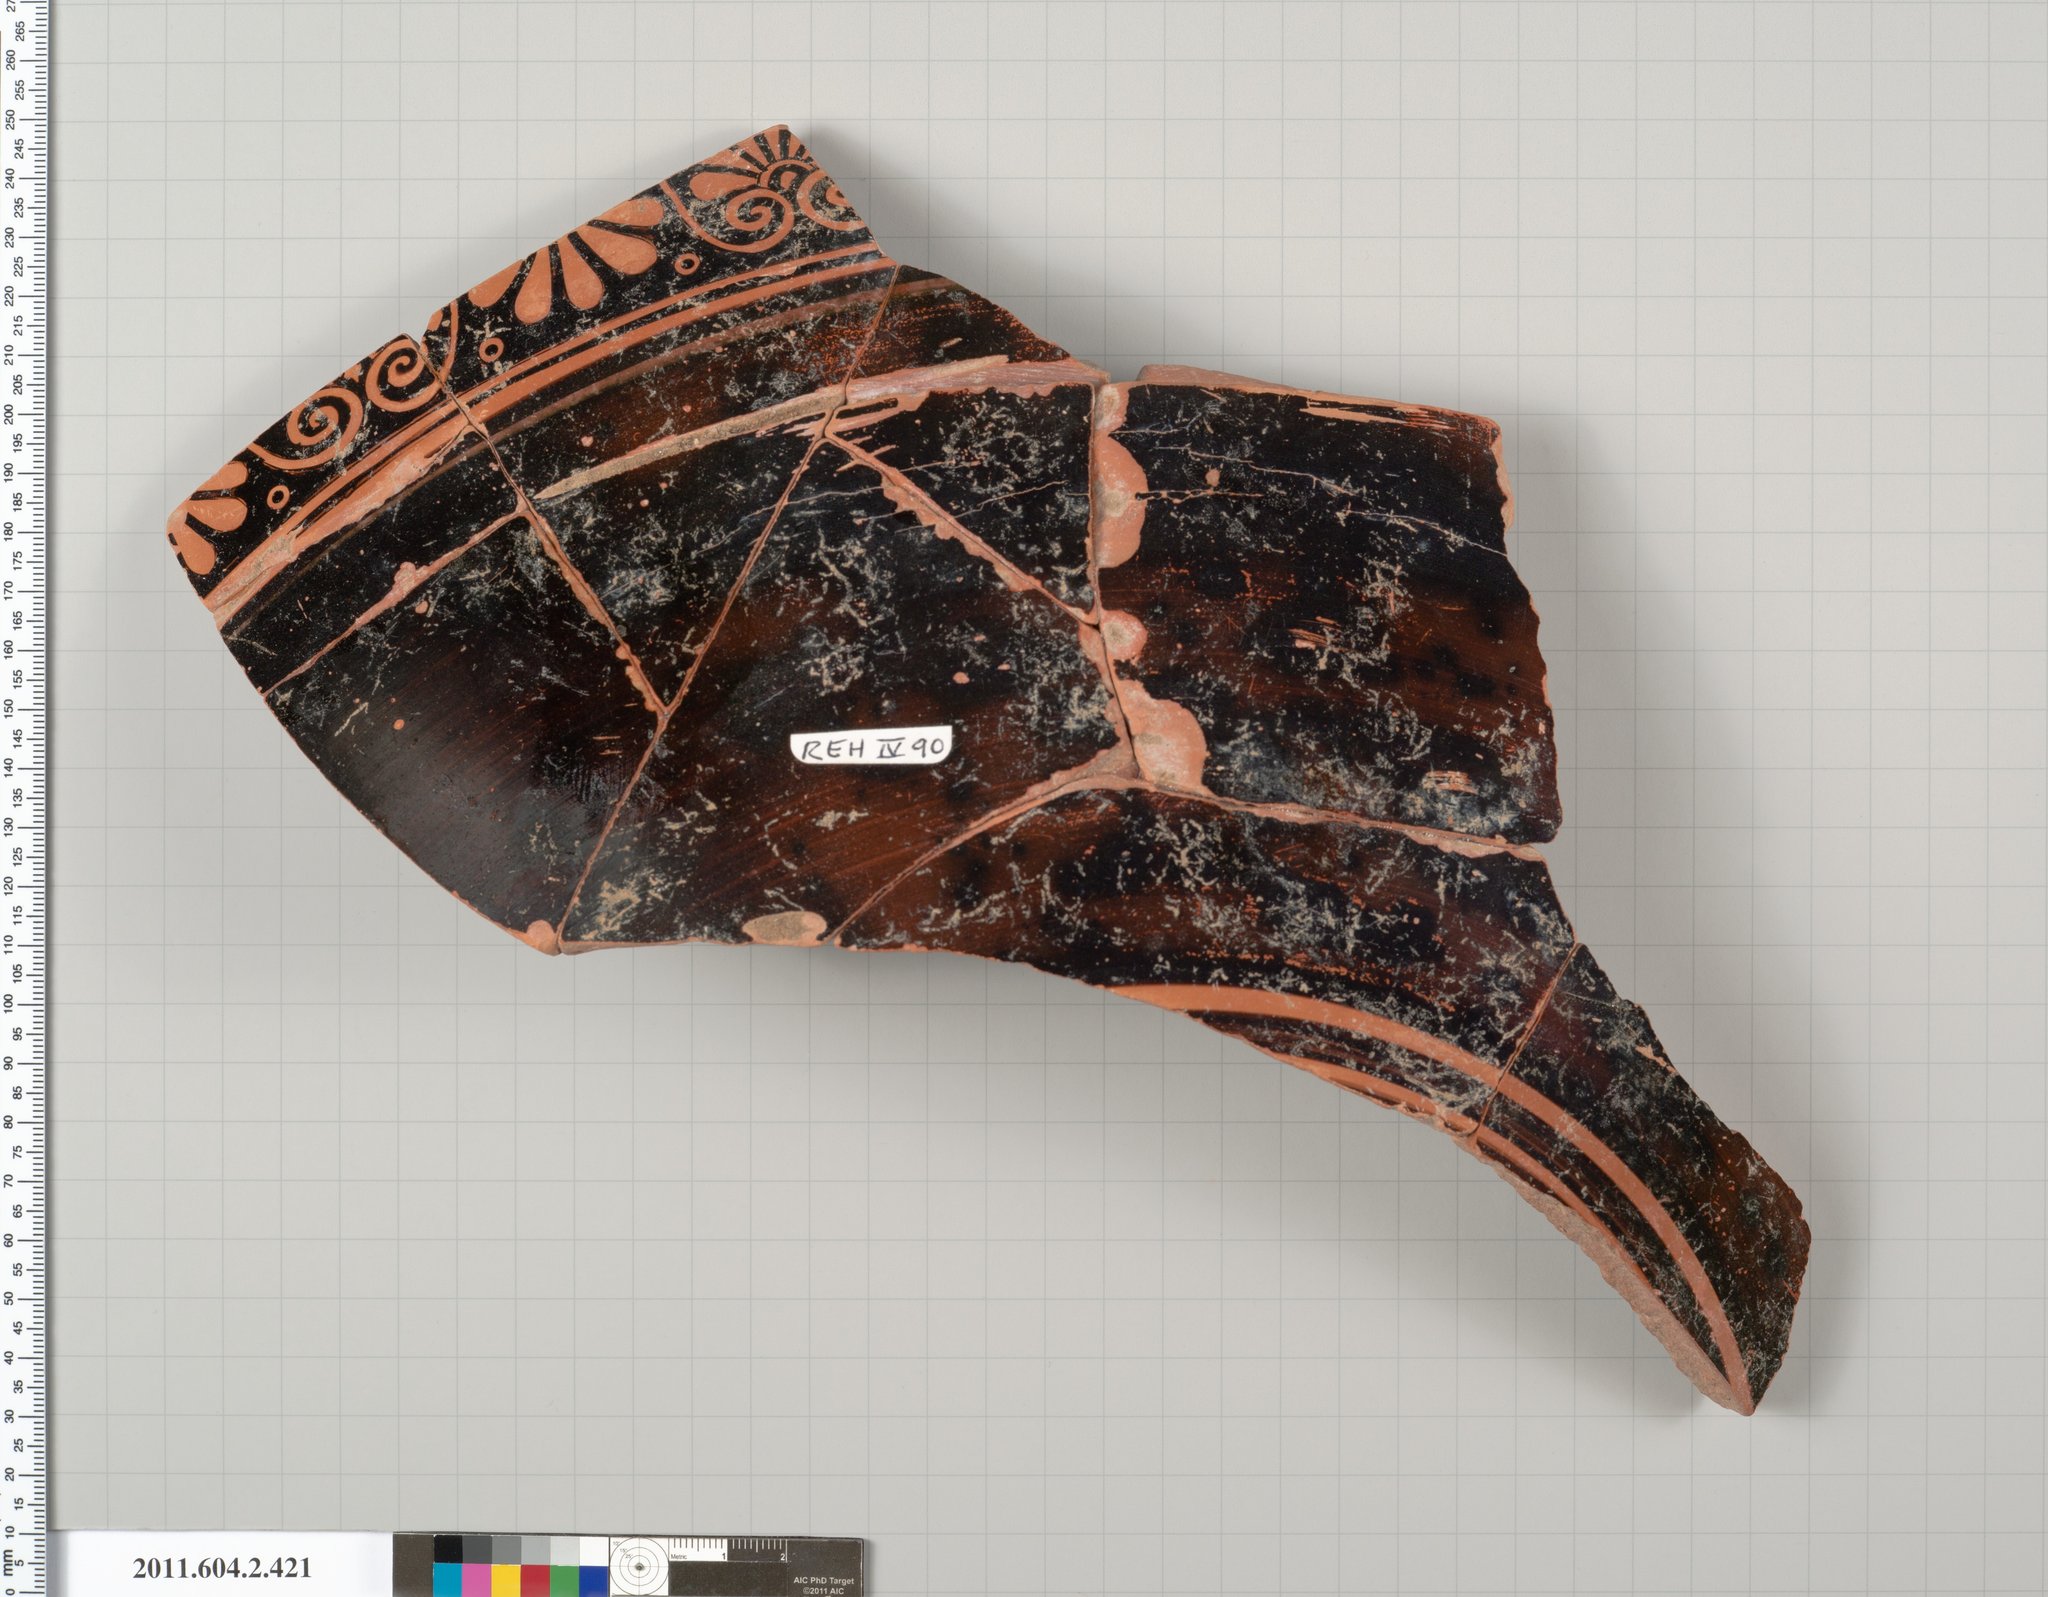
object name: column krater fragment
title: Terracotta fragment of a dinos? (deep round-bottomed bowl) or column-krater (bowl for mixing wine and water)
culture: greek, attic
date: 480-470 BCE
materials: terracotta